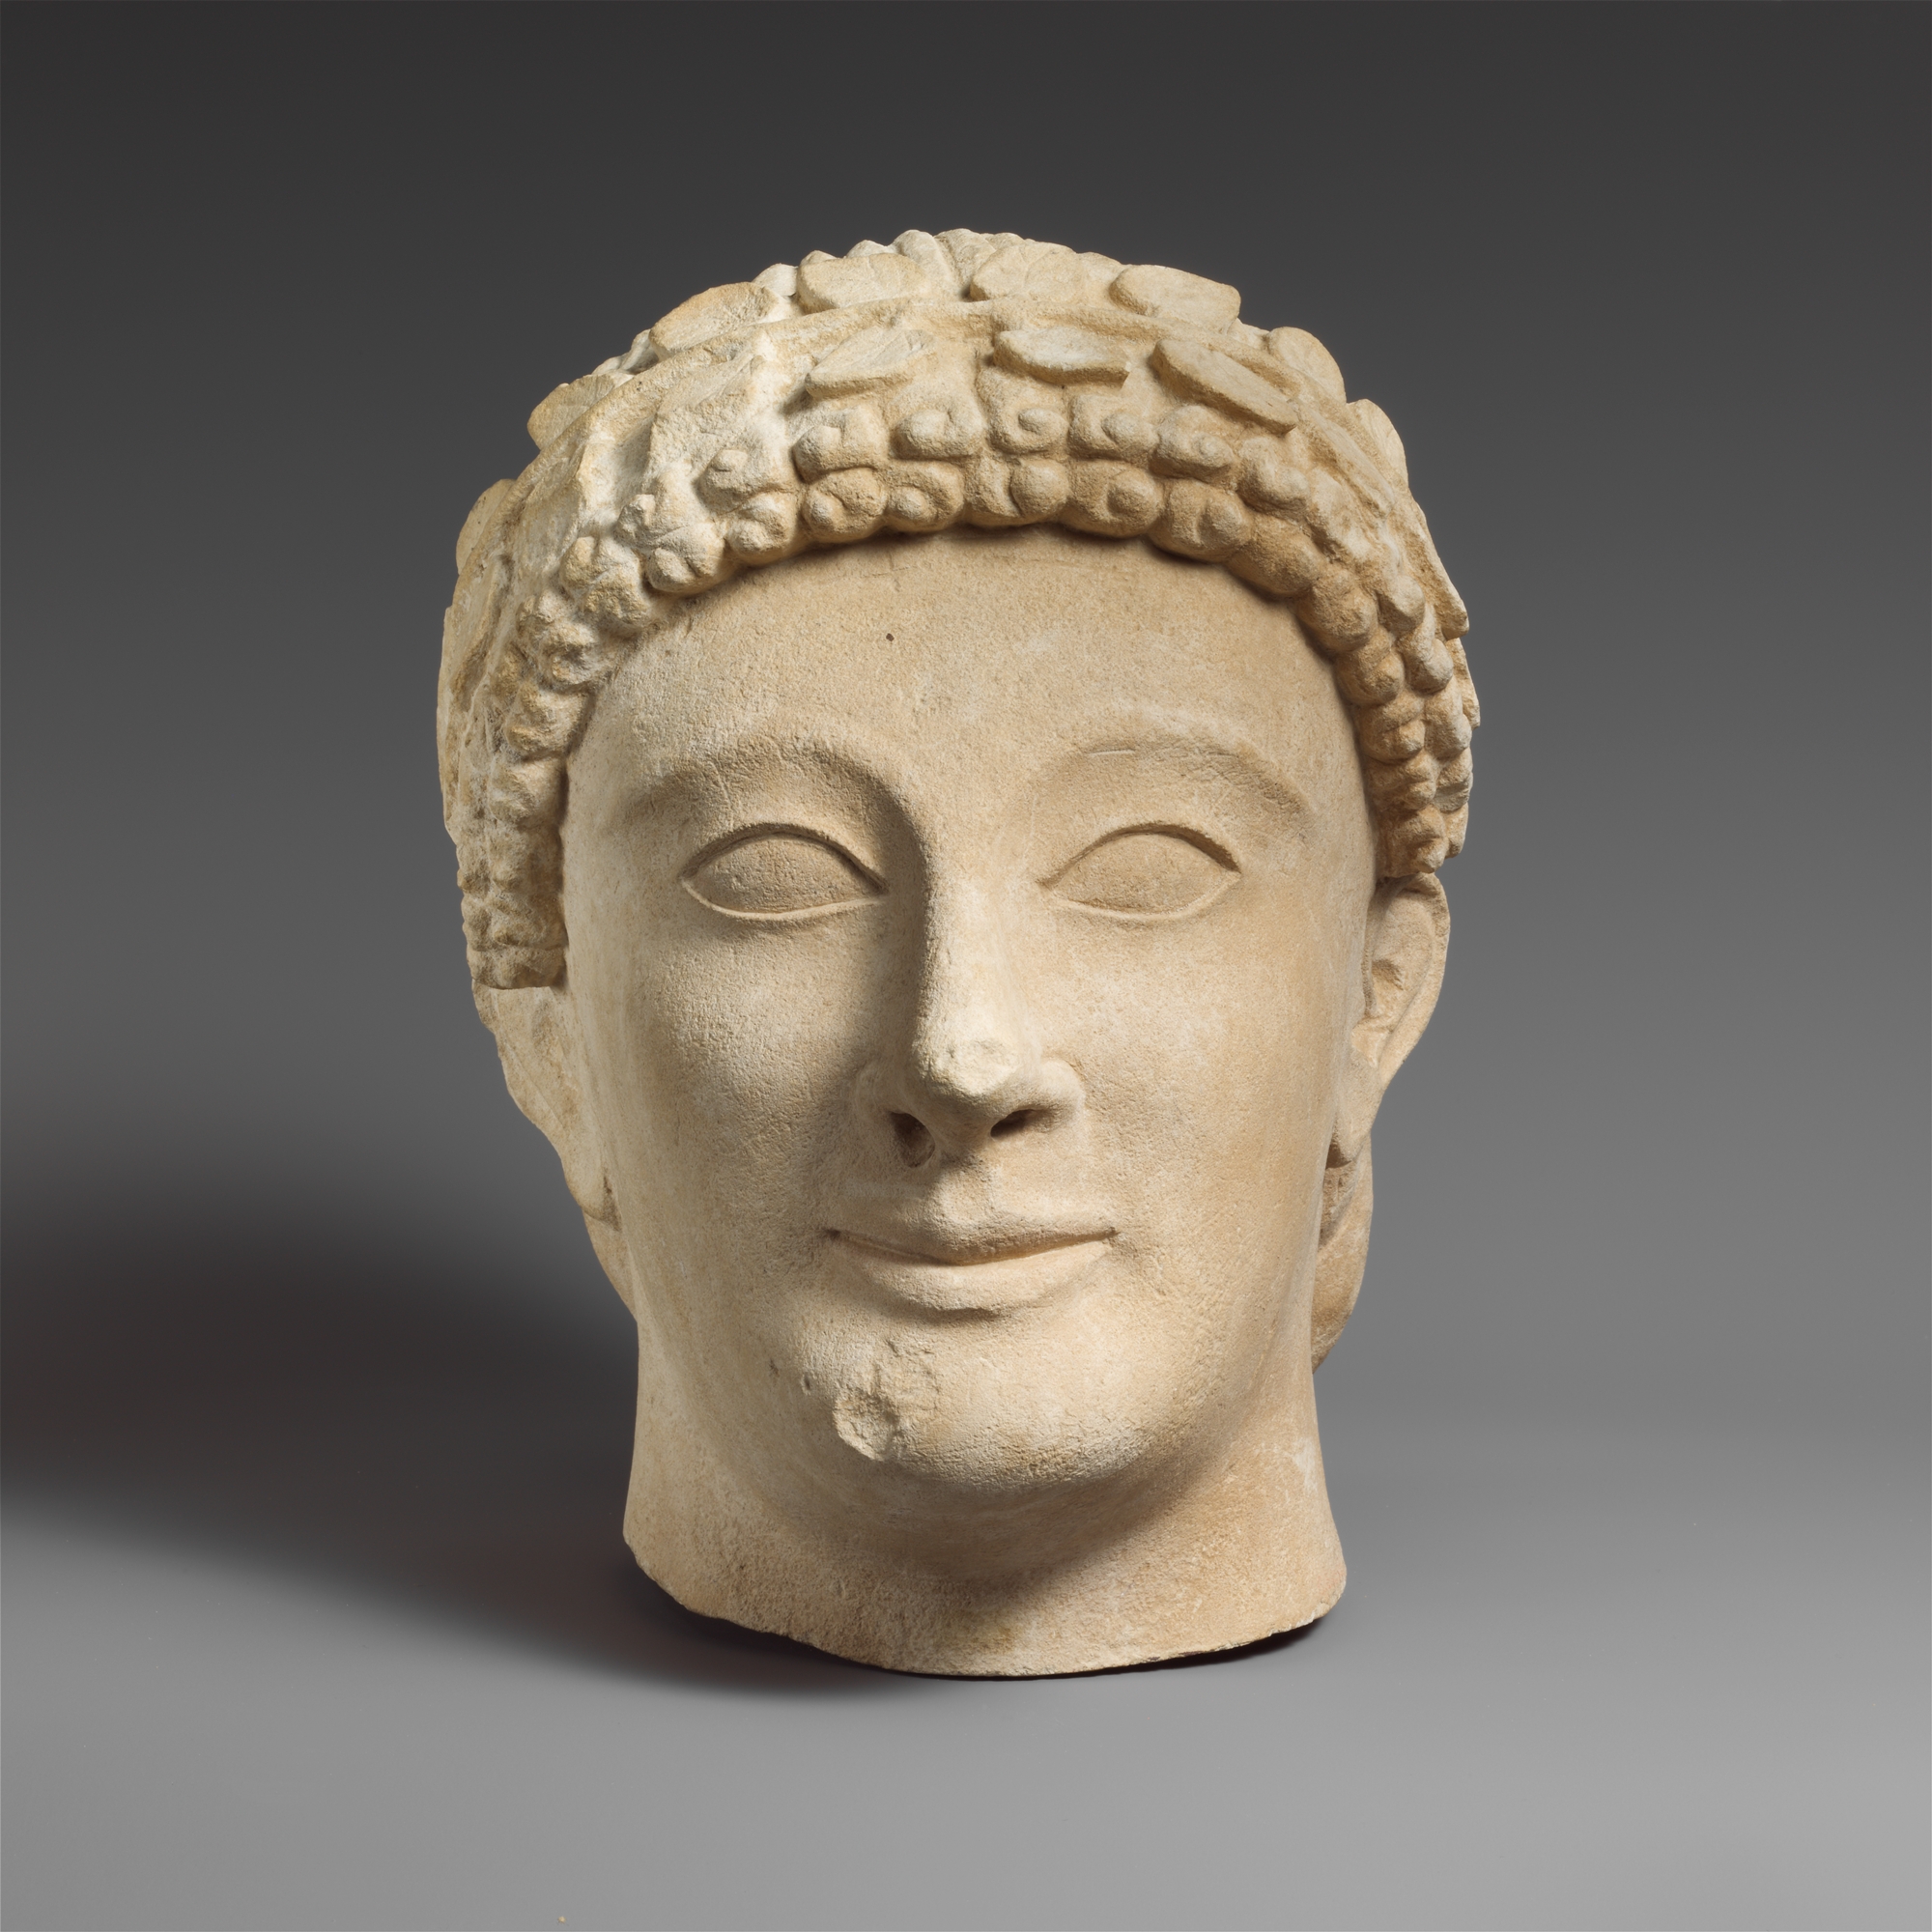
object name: beardless head of male votary with wreath of leaf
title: Limestone head of a beardless male votary with a wreath of leaves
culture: cypriot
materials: limestone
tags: heads,men,leaves,wreaths